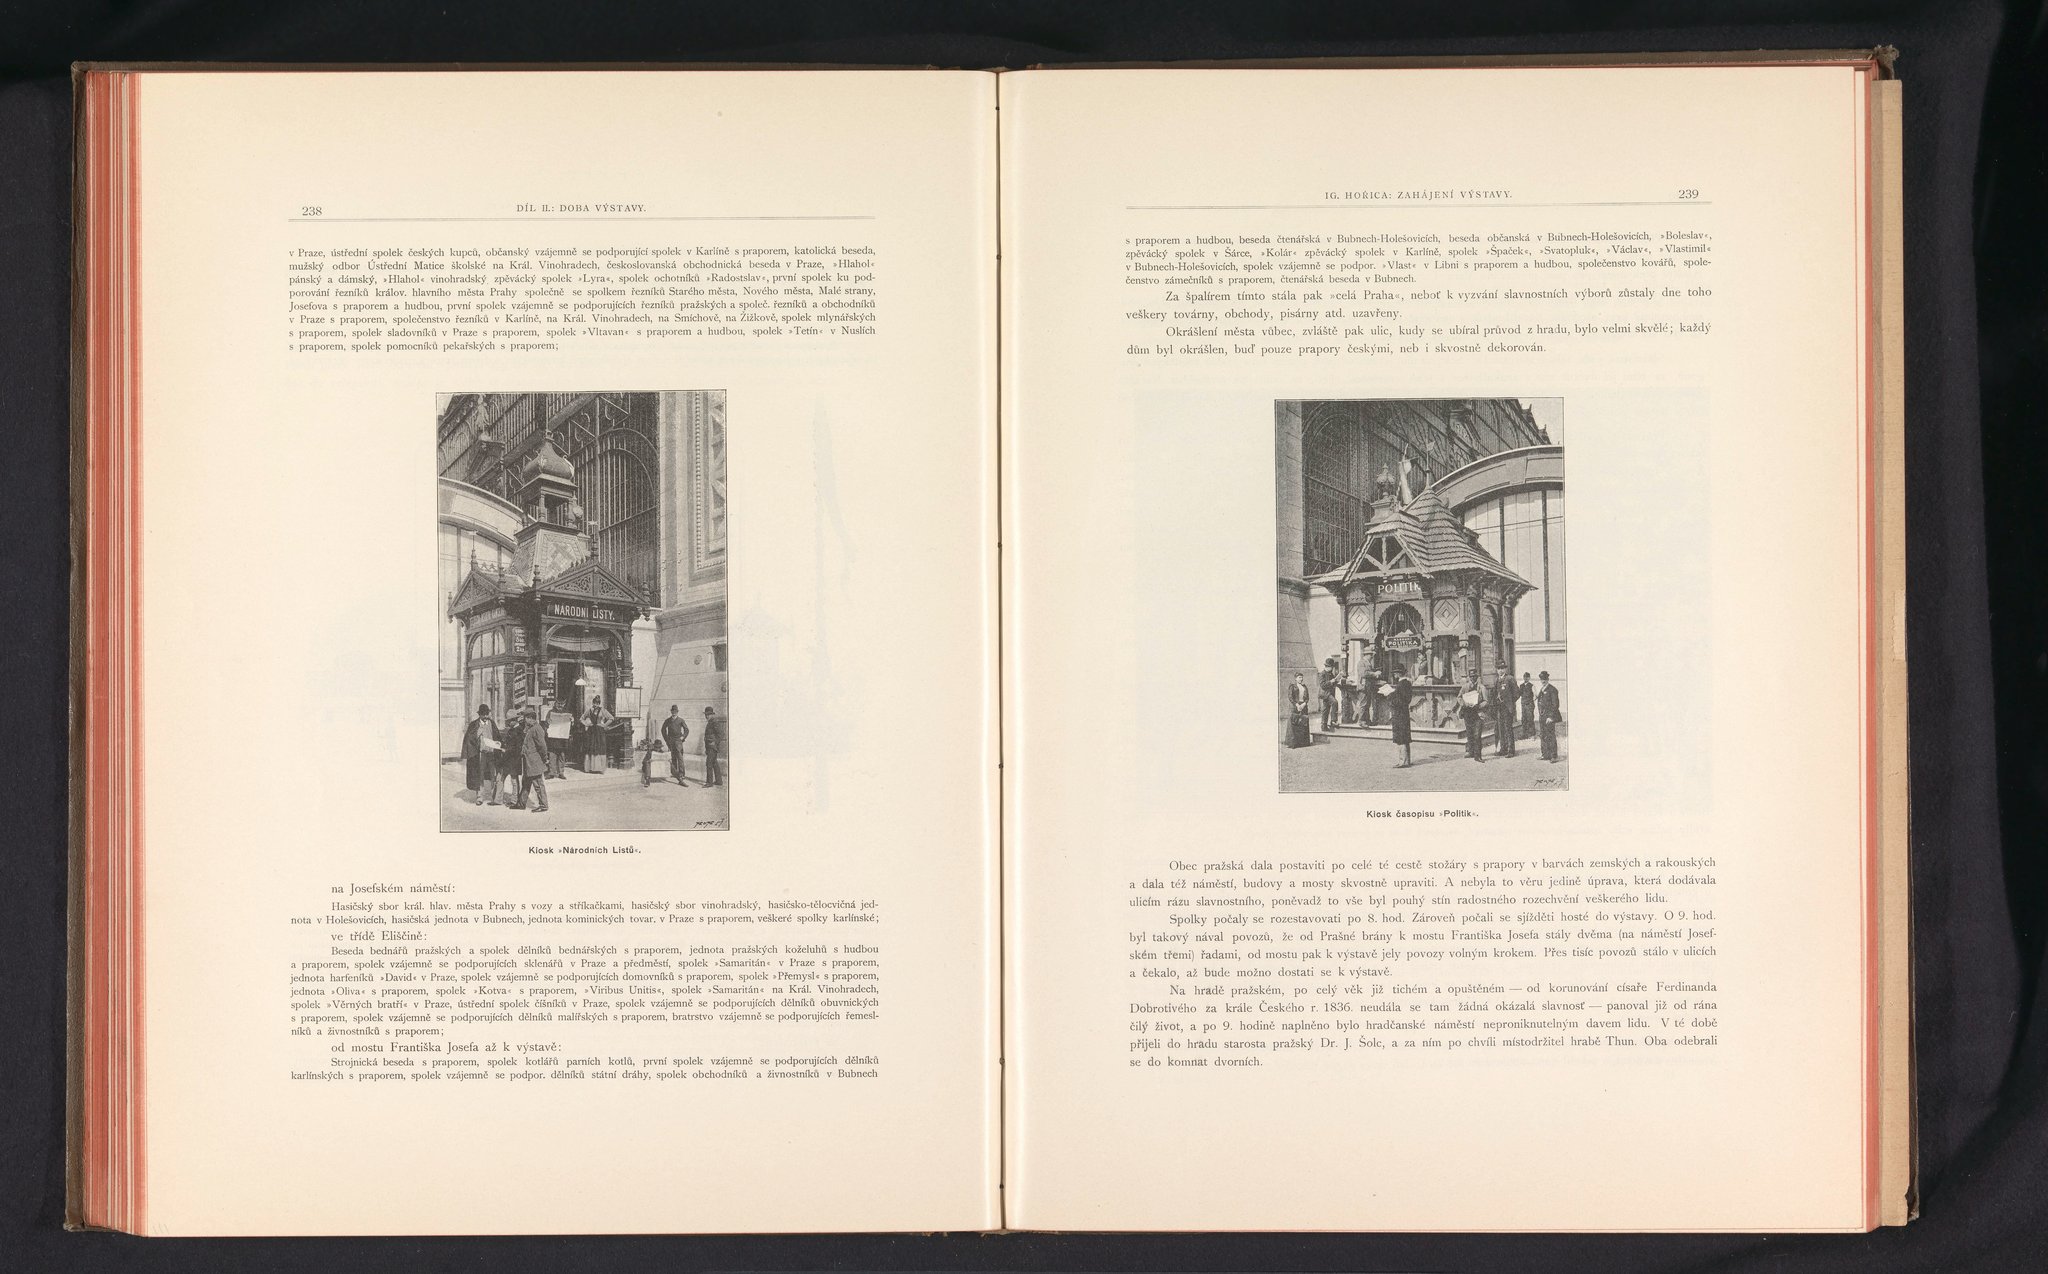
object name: photomechanical print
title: Kiosk ,,Narodnich Listu"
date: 1891-1893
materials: paper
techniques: autotype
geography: prague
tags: book-stall, kiosk